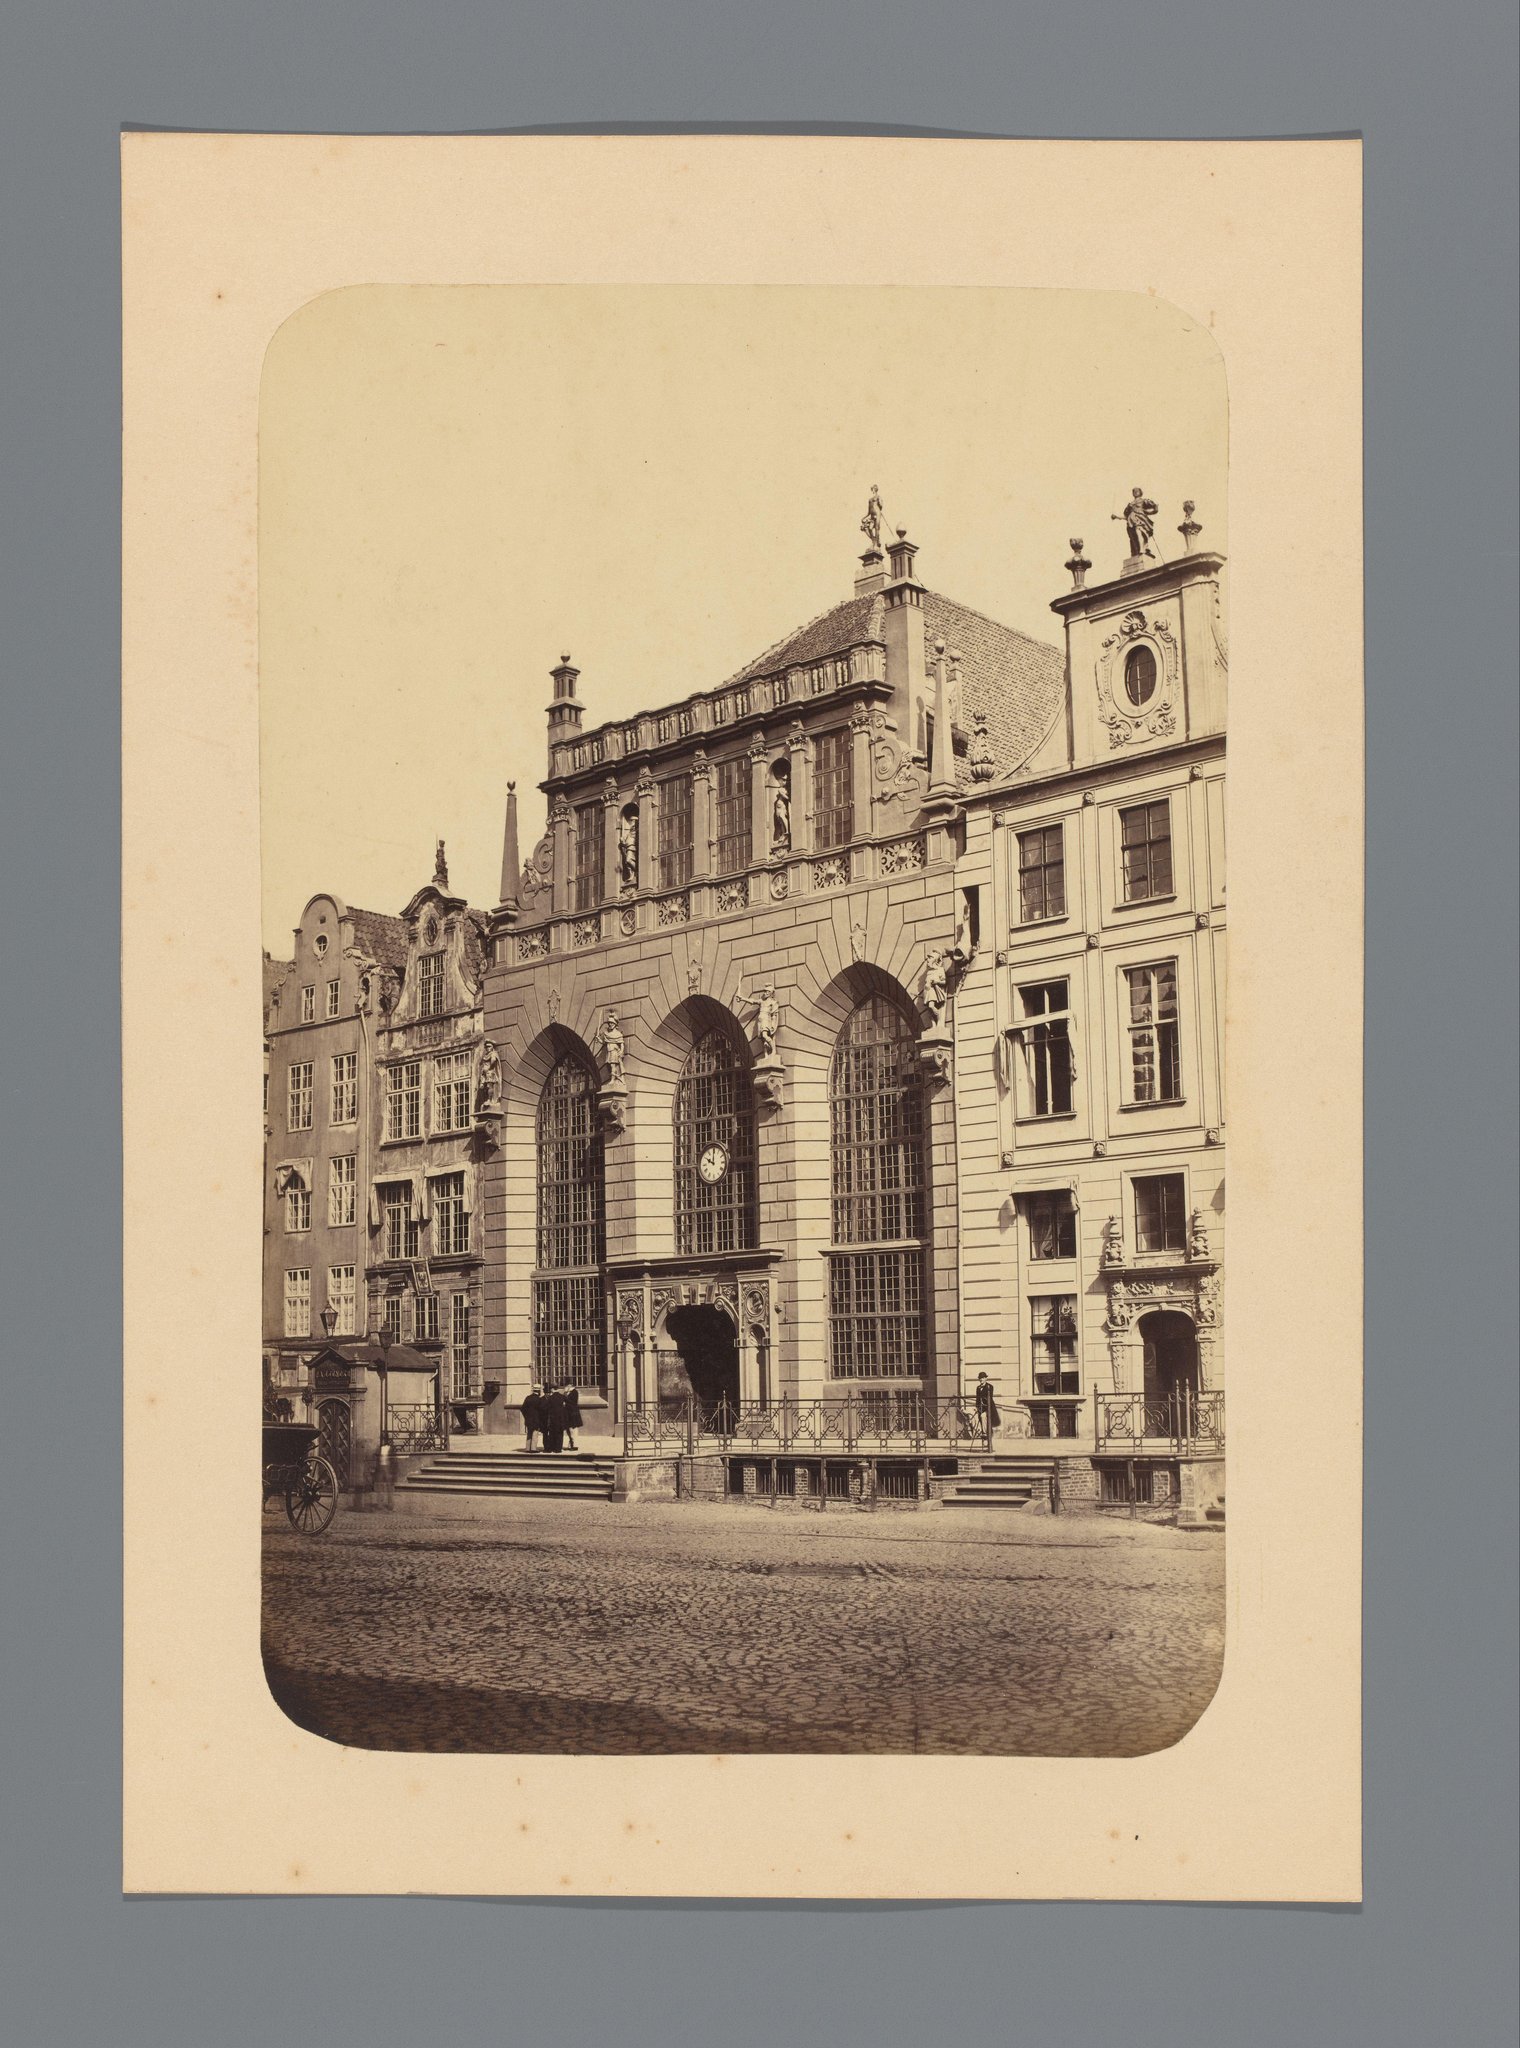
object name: photograph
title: Danzig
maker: Anonymous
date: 1850-1890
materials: cardboard, photographic support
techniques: albumen print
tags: danzig